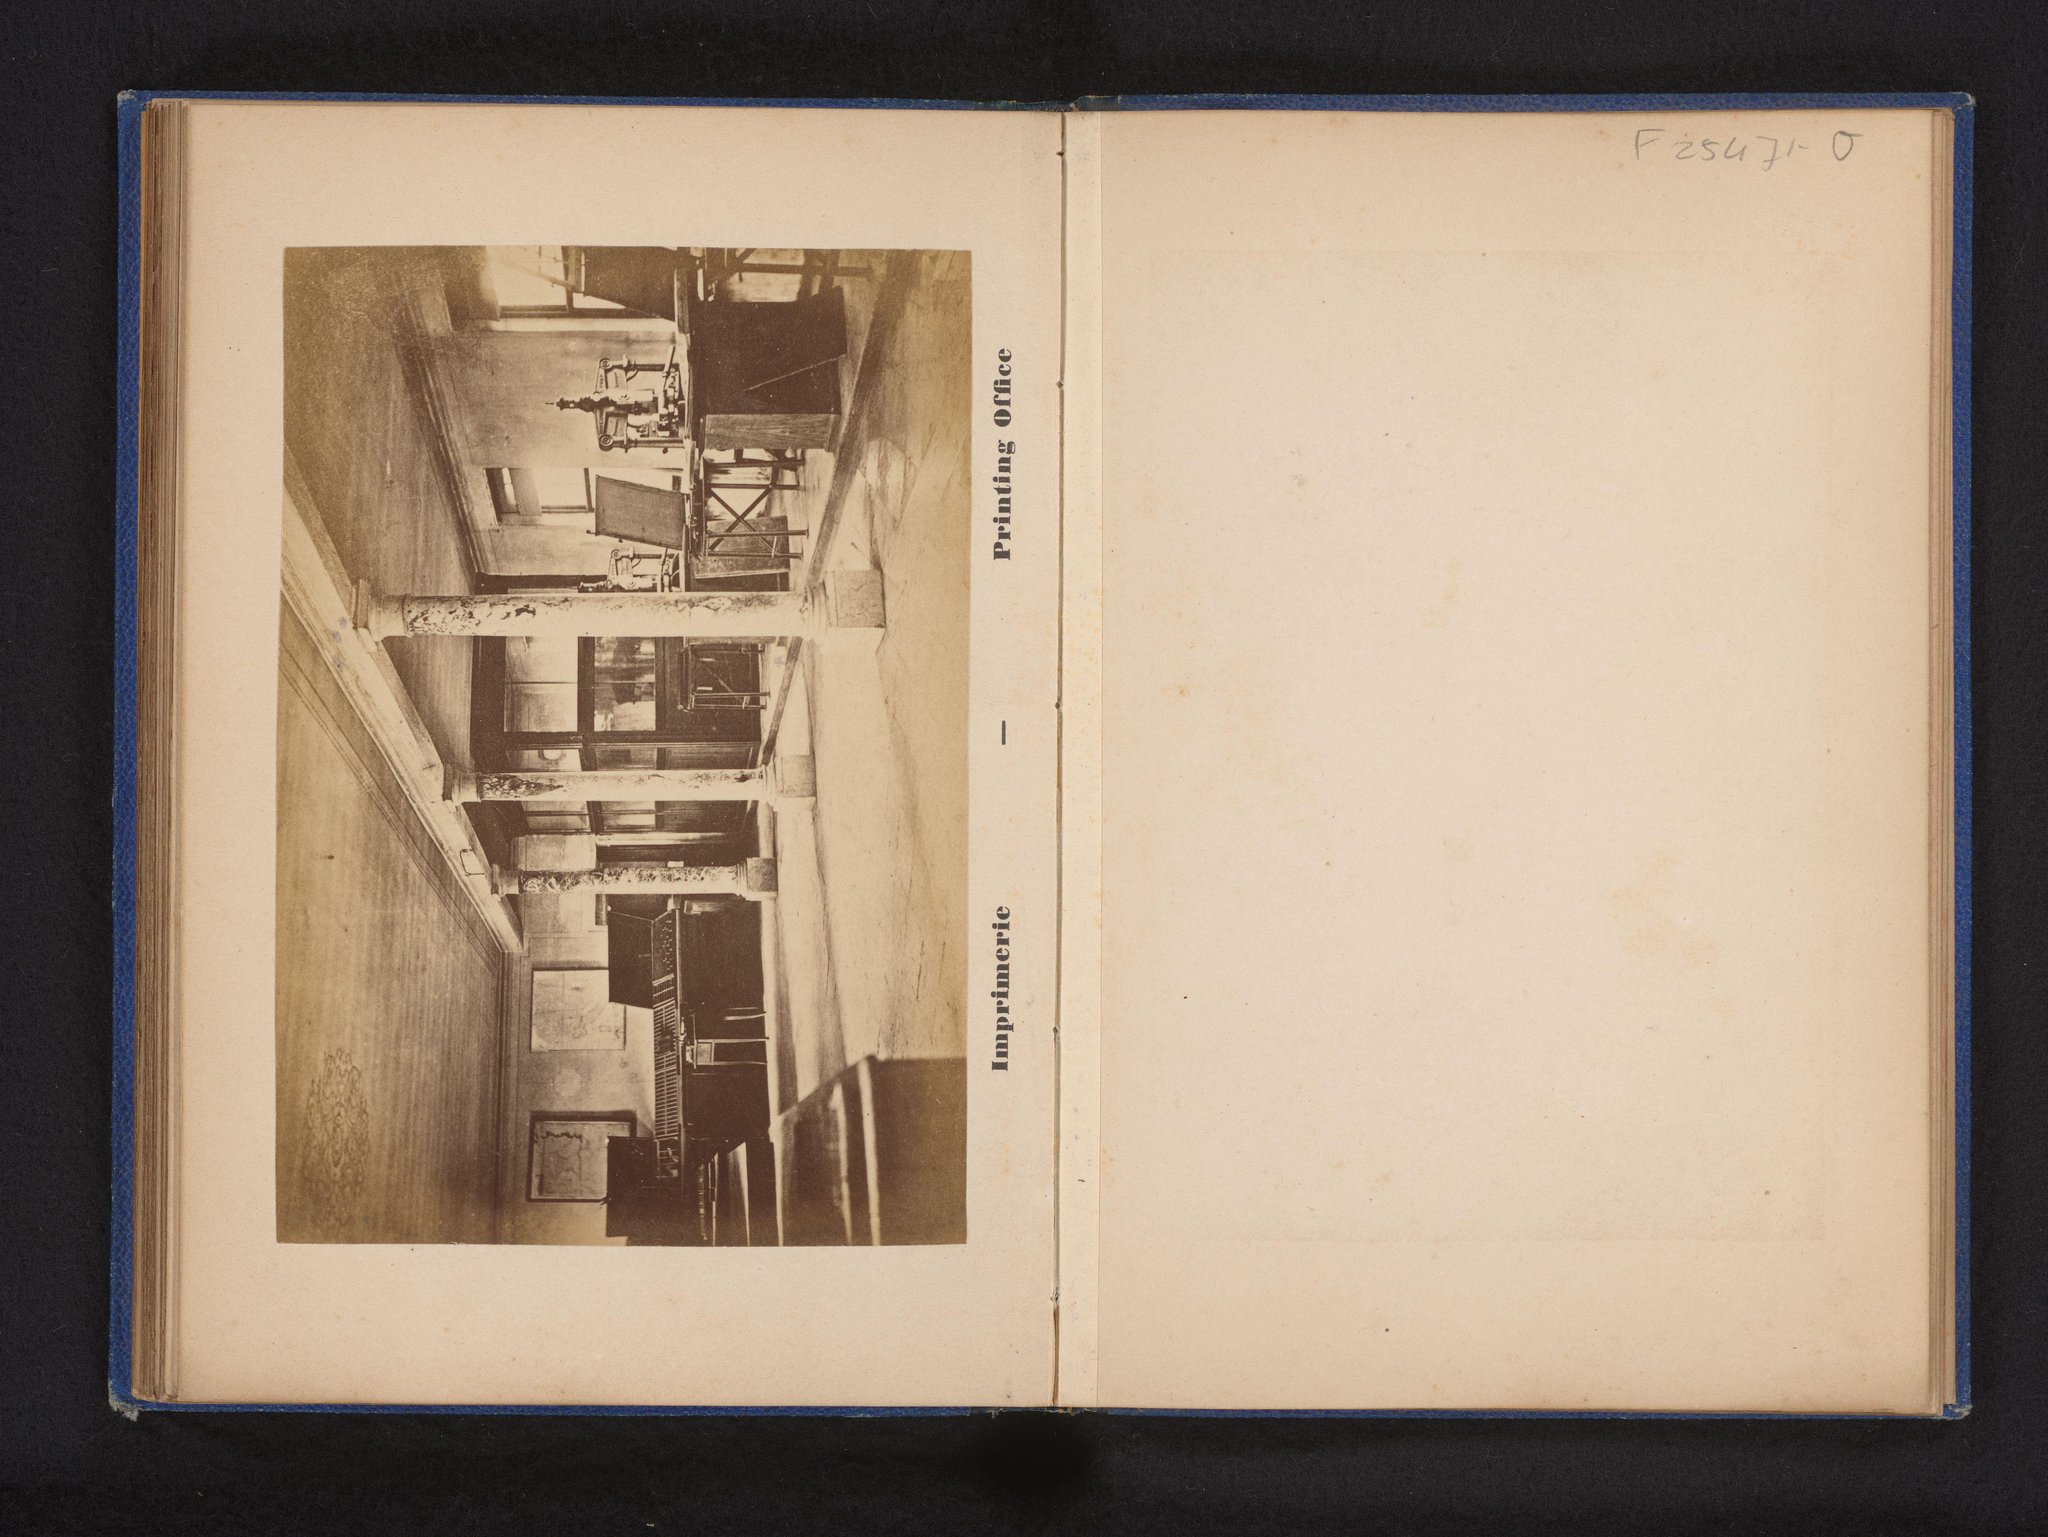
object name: page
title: Boekdrukkerij in het klooster van San Lazzaro degli Armeni, Venetië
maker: Anonymous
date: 1874-1879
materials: paper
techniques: albumen print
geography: venice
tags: printing, printing office